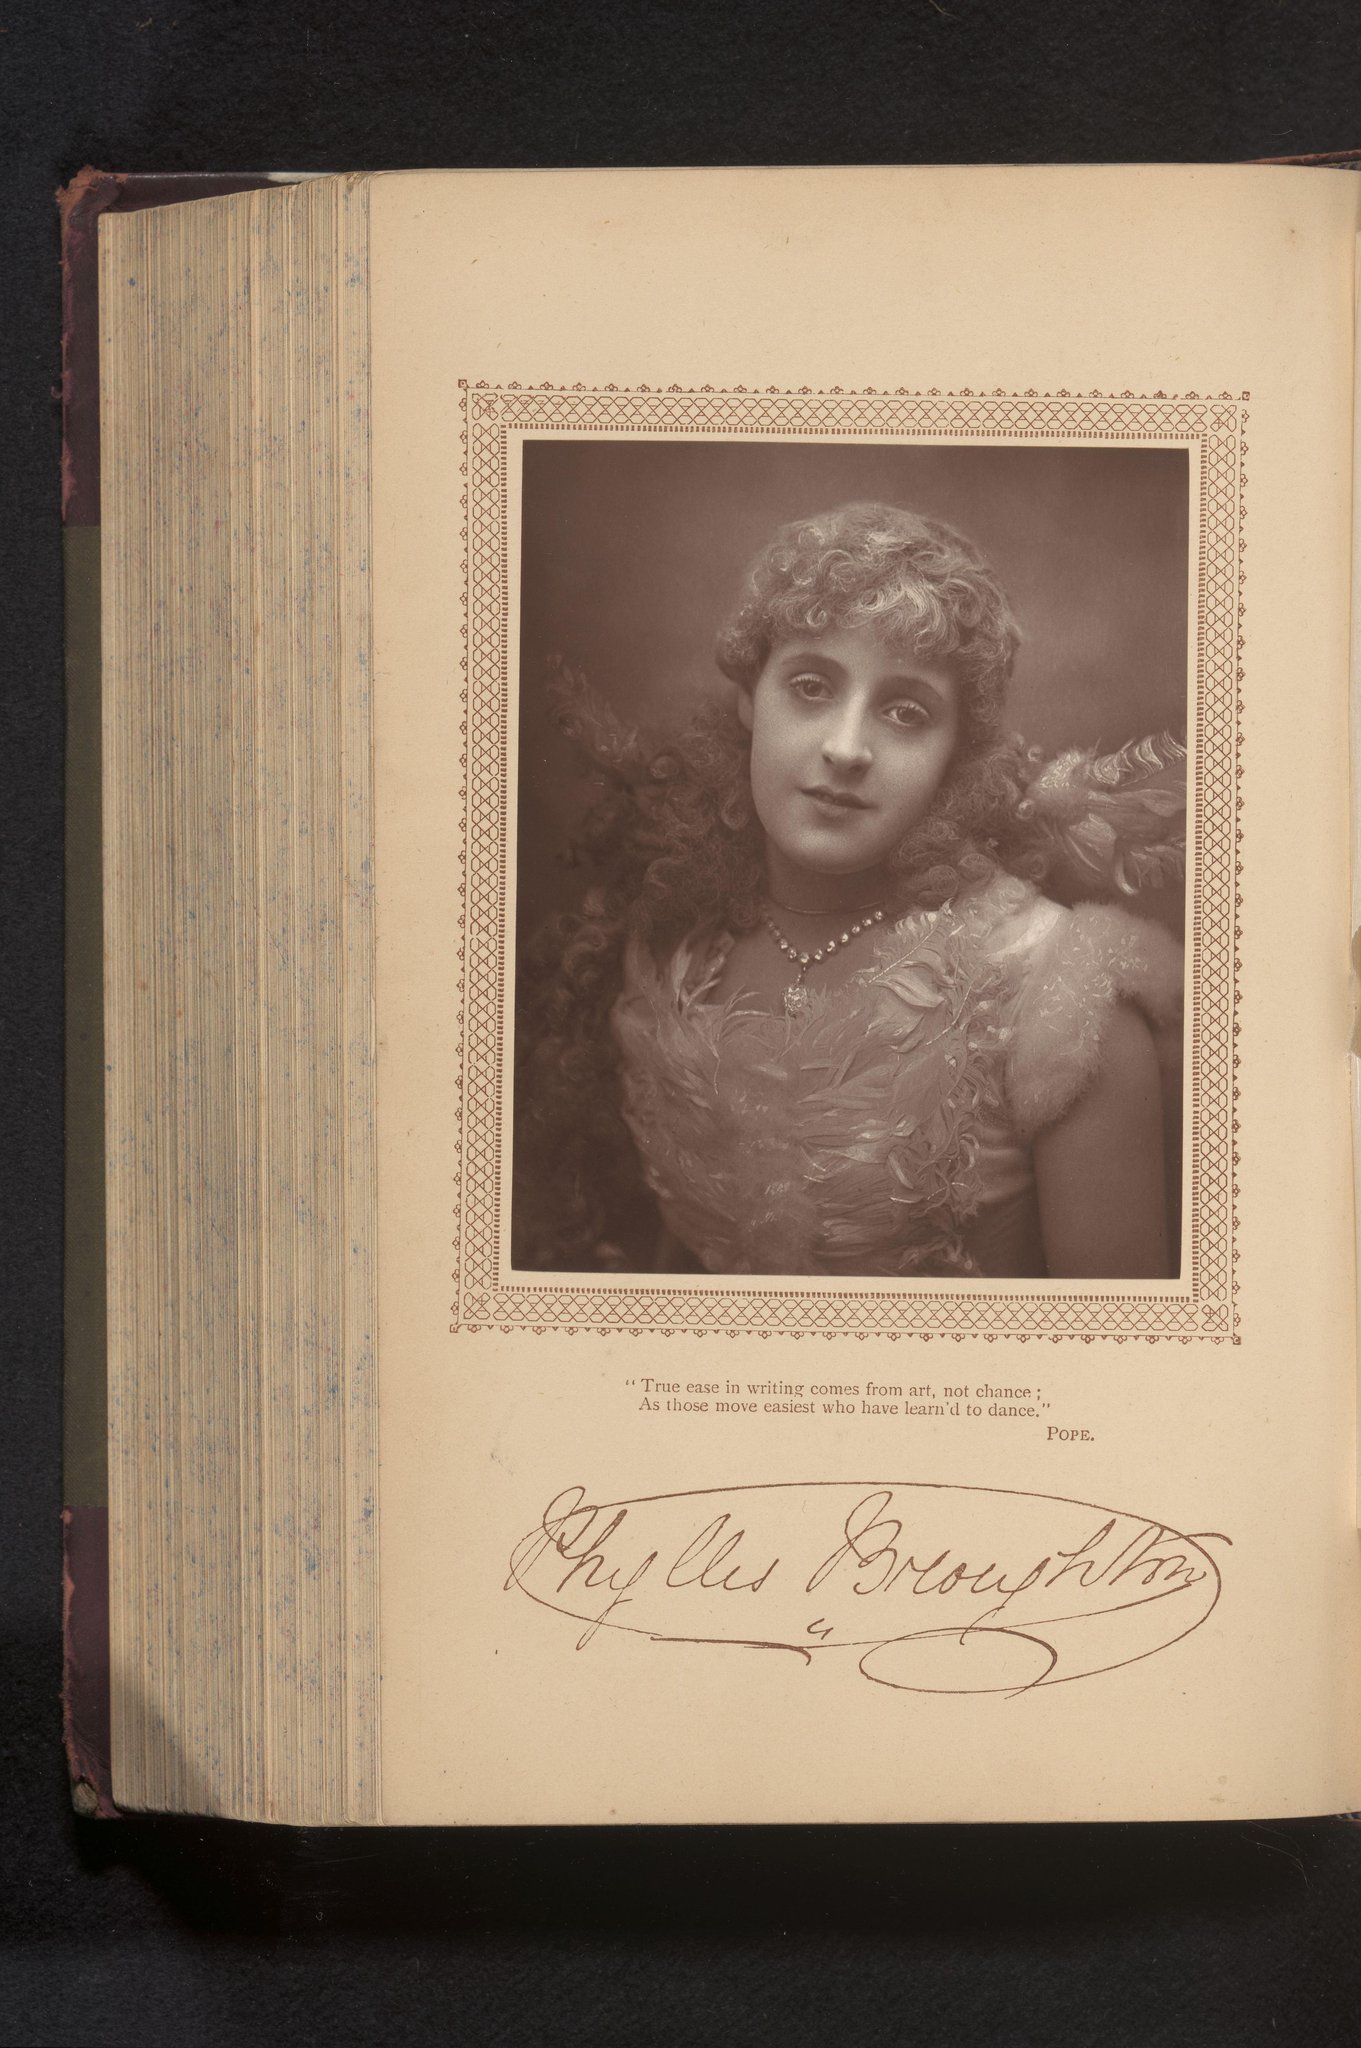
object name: page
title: Portret van Phyllis Broughton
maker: Anonymous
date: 1879-1884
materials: paper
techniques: woodburytype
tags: adult woman, historical persons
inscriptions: signature: ‘Phyllis Broughton’, inscription: ‘/True ease in writing comes from art, not chance:/ As those move easiest who have learn'd to dance.'/ Pope’